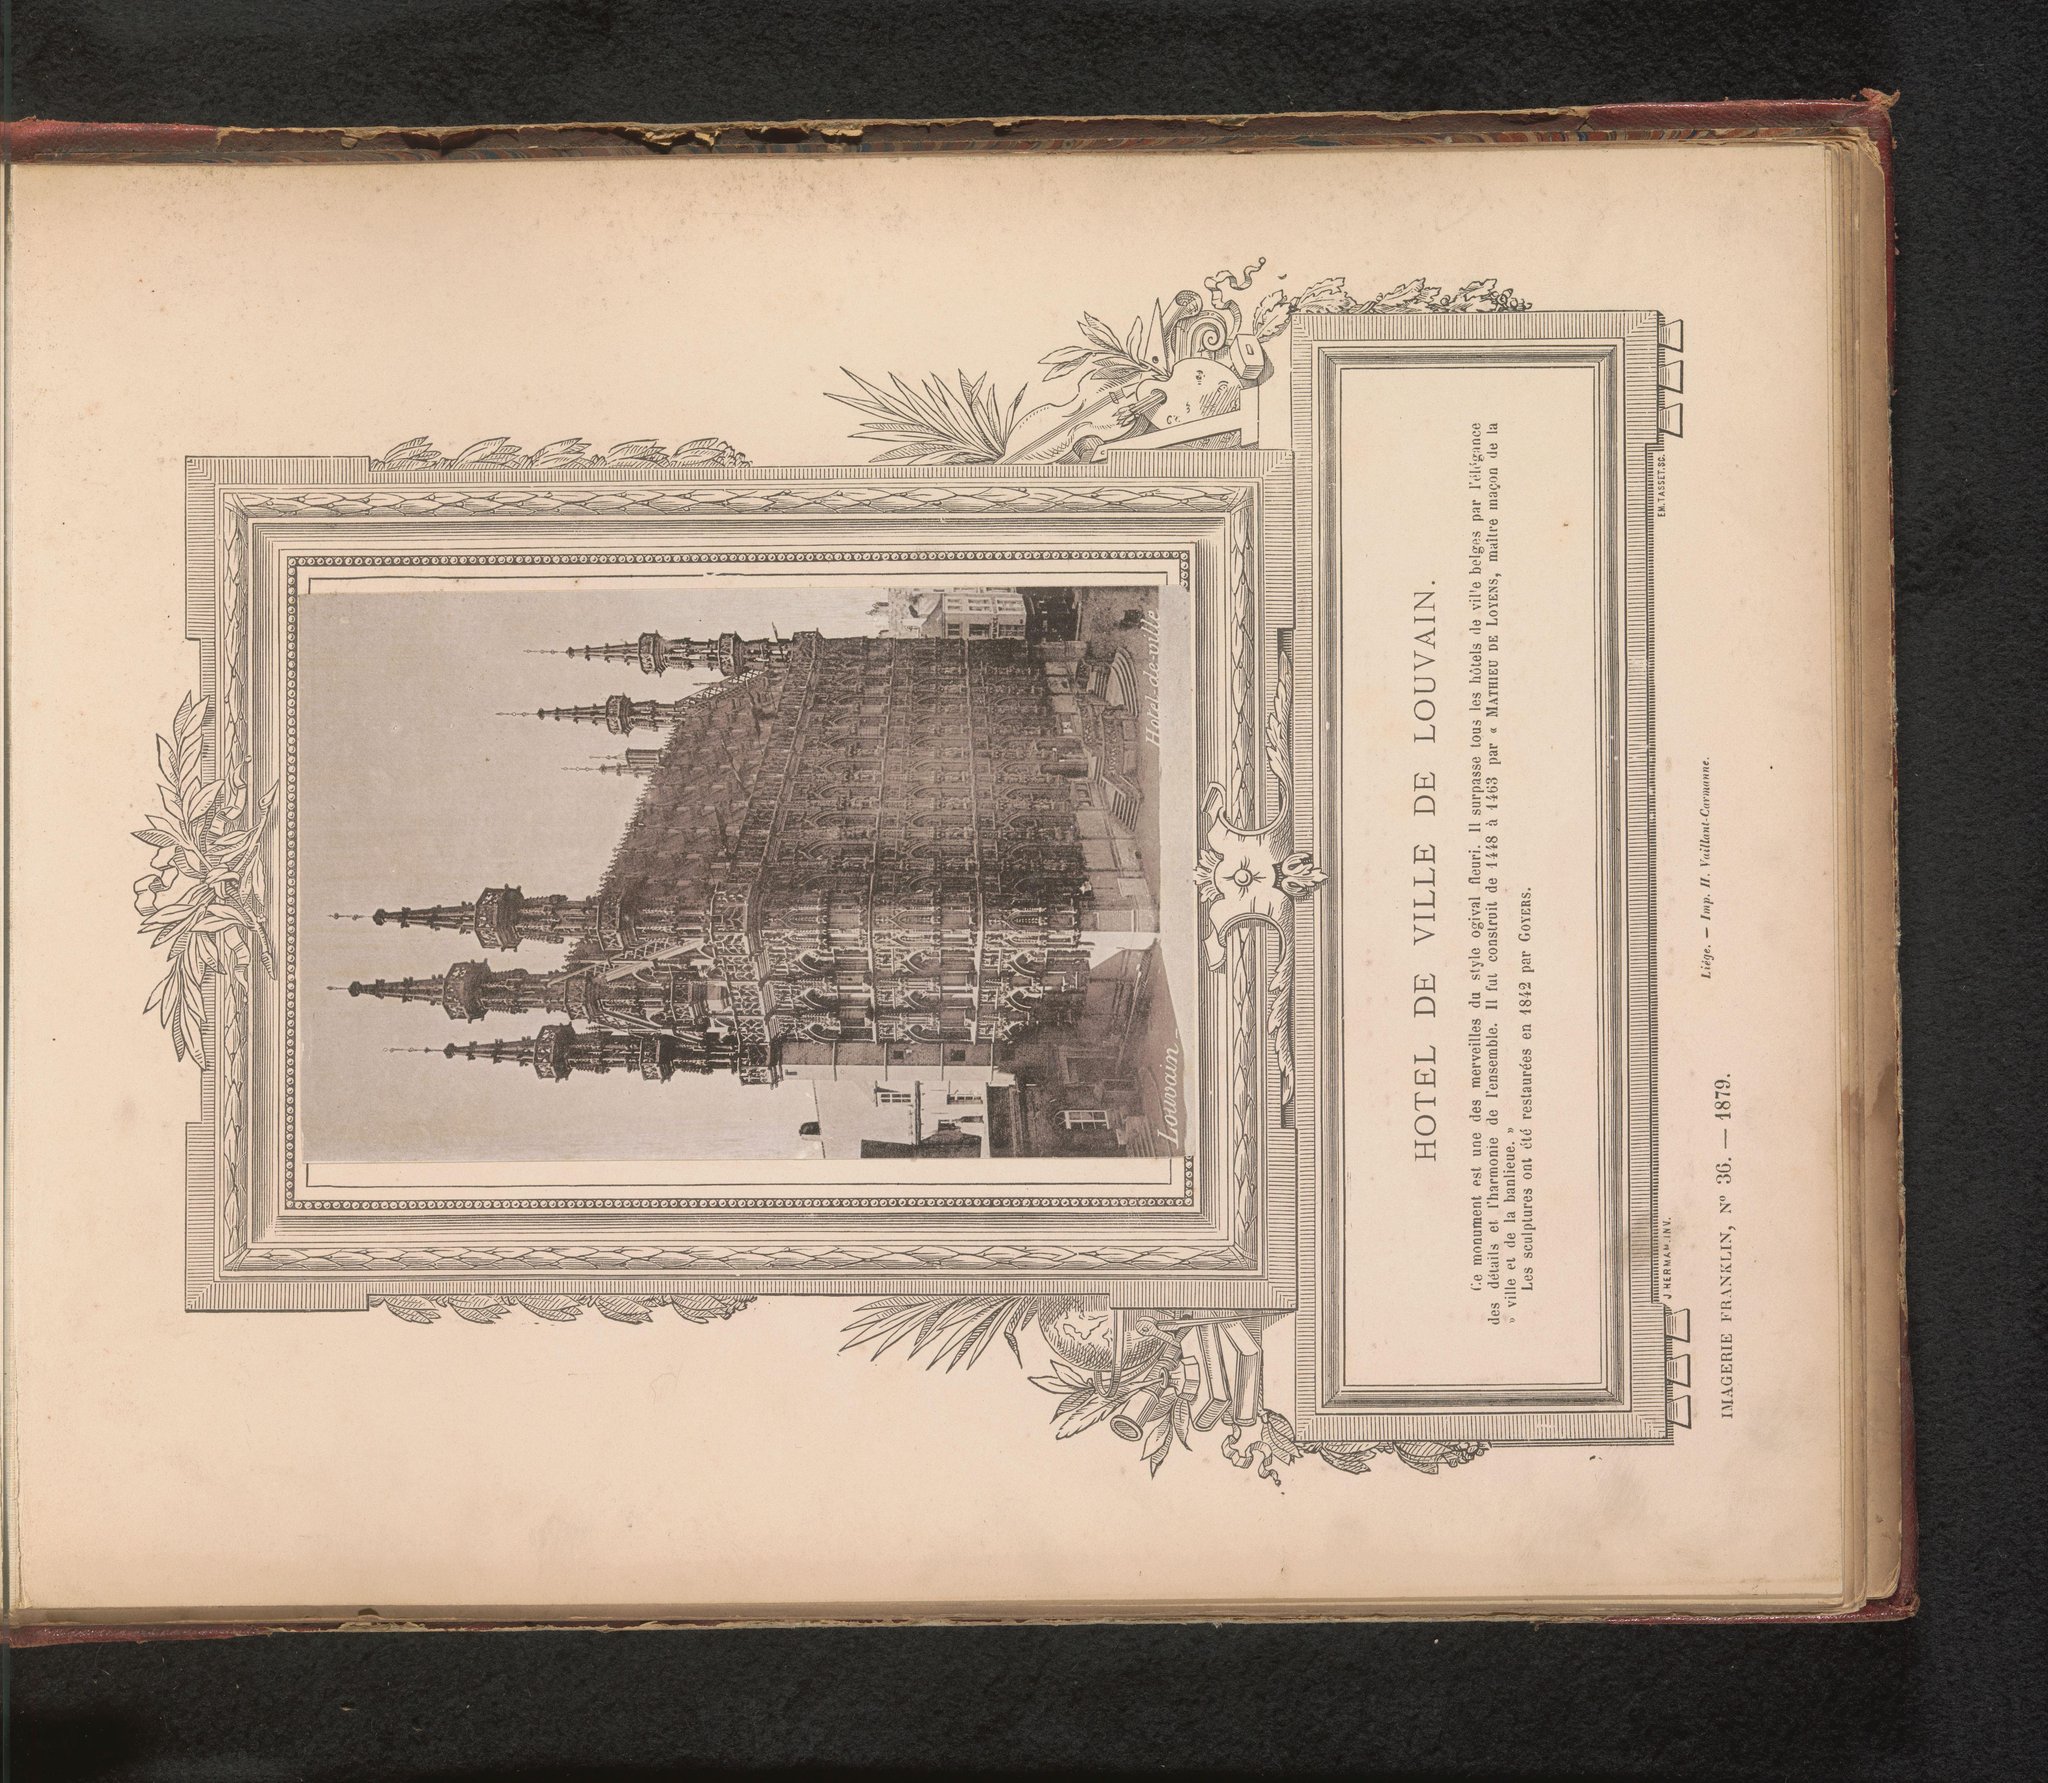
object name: page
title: Hotel de Ville de Louvain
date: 1874-1879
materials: paper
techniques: photograph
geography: liège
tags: townhall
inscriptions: inscription: ‘Ce monument (...) par Goyers.’, inscription: ‘IMAGERIE FRANKLIN, No 36. -1879.’, name: ‘J. HERMAN, INV.’, name: ‘EM. TASSET, SC.’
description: Deze prent maakt deel uit van een album.